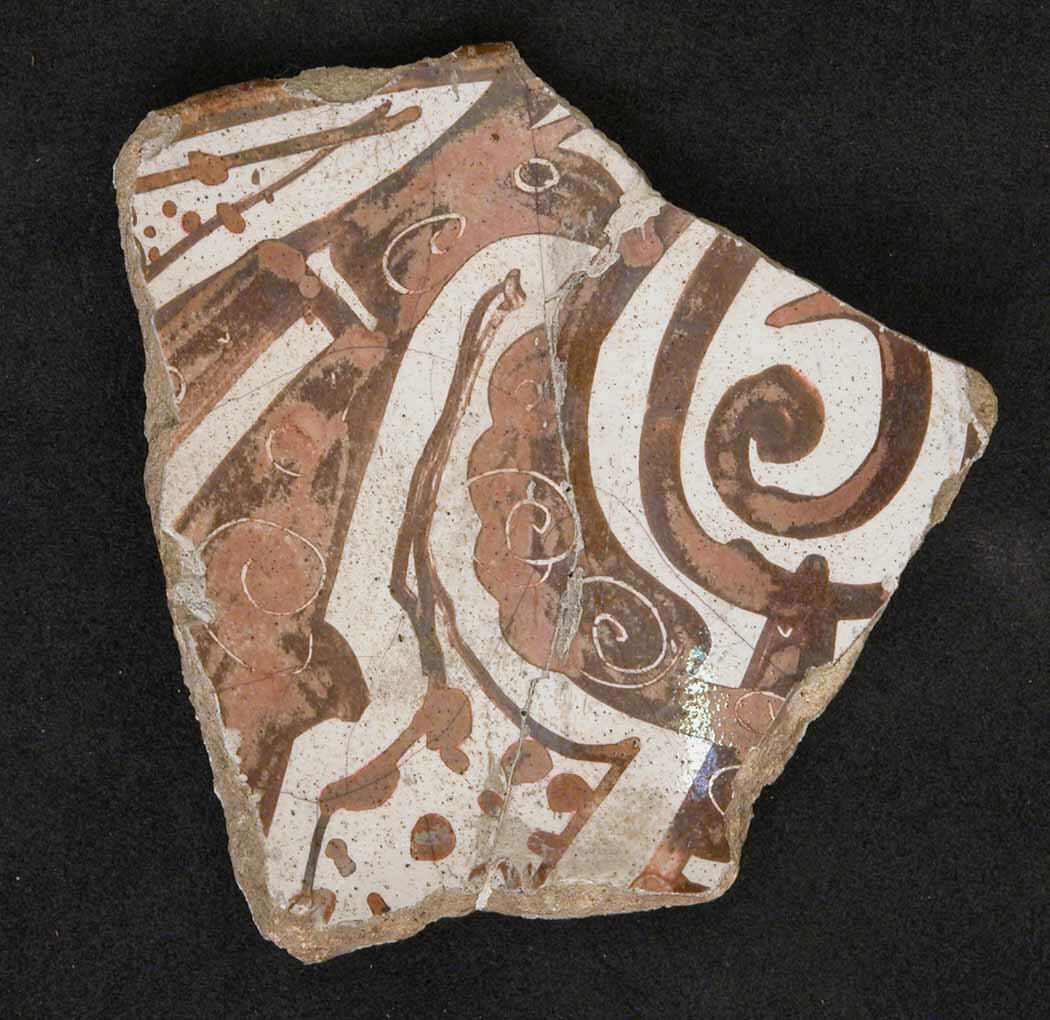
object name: ceramic fragment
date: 1201-1400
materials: stonepaste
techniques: luster painting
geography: syria